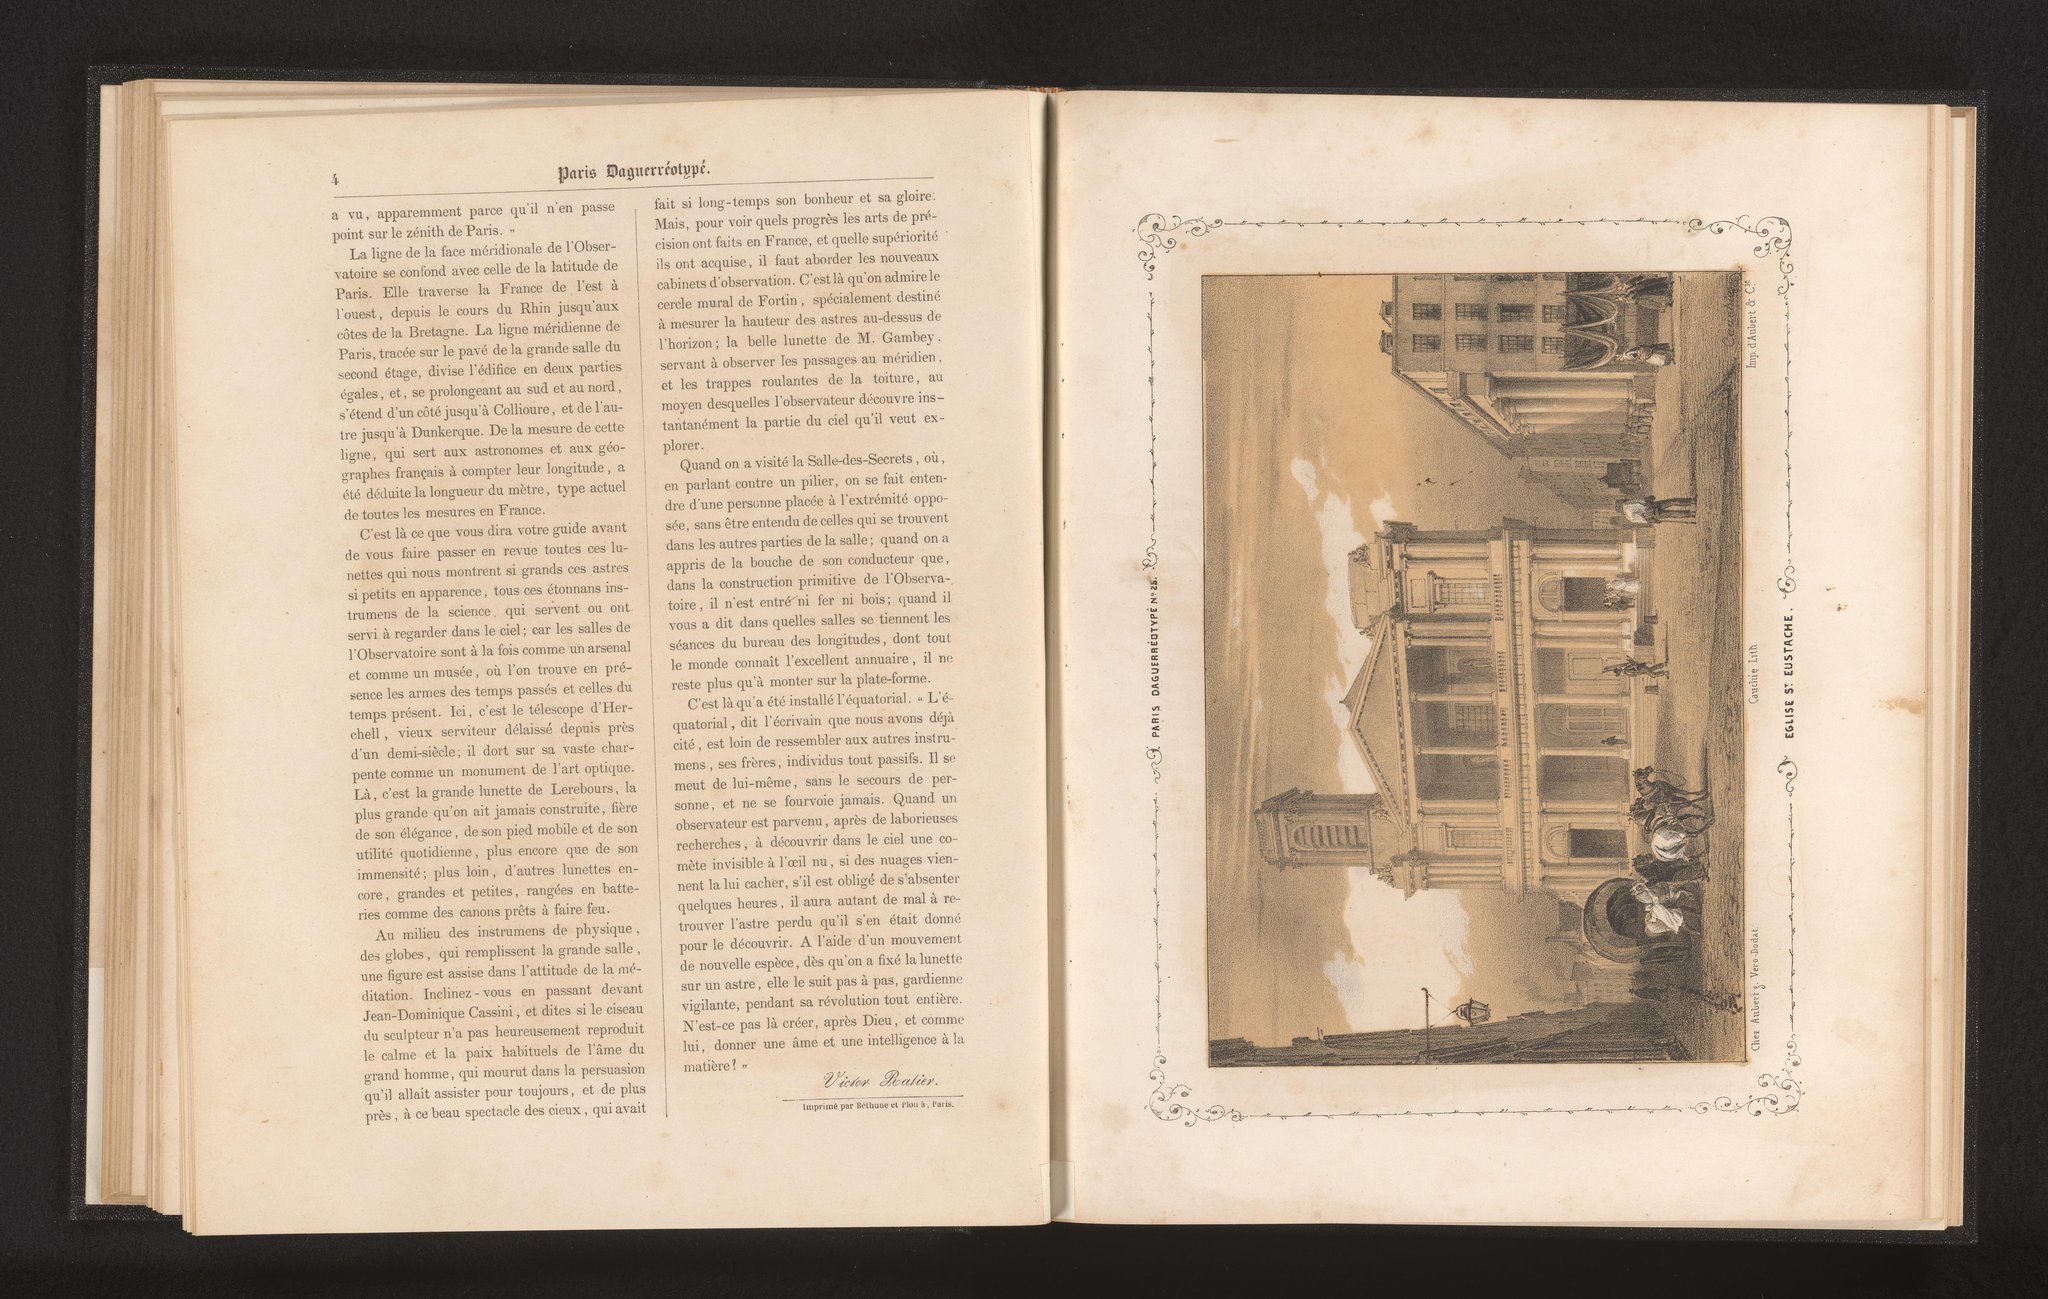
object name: print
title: Gezicht op de Église Saint-Eustache in Parijs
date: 1839-1840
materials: paper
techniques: tone lithography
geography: paris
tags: church (exterior)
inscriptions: inscription: ‘PARIS DAGUERRÉOTYPÉ No. 25.’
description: Prent op negenennegentigste ongenummerde pagina.